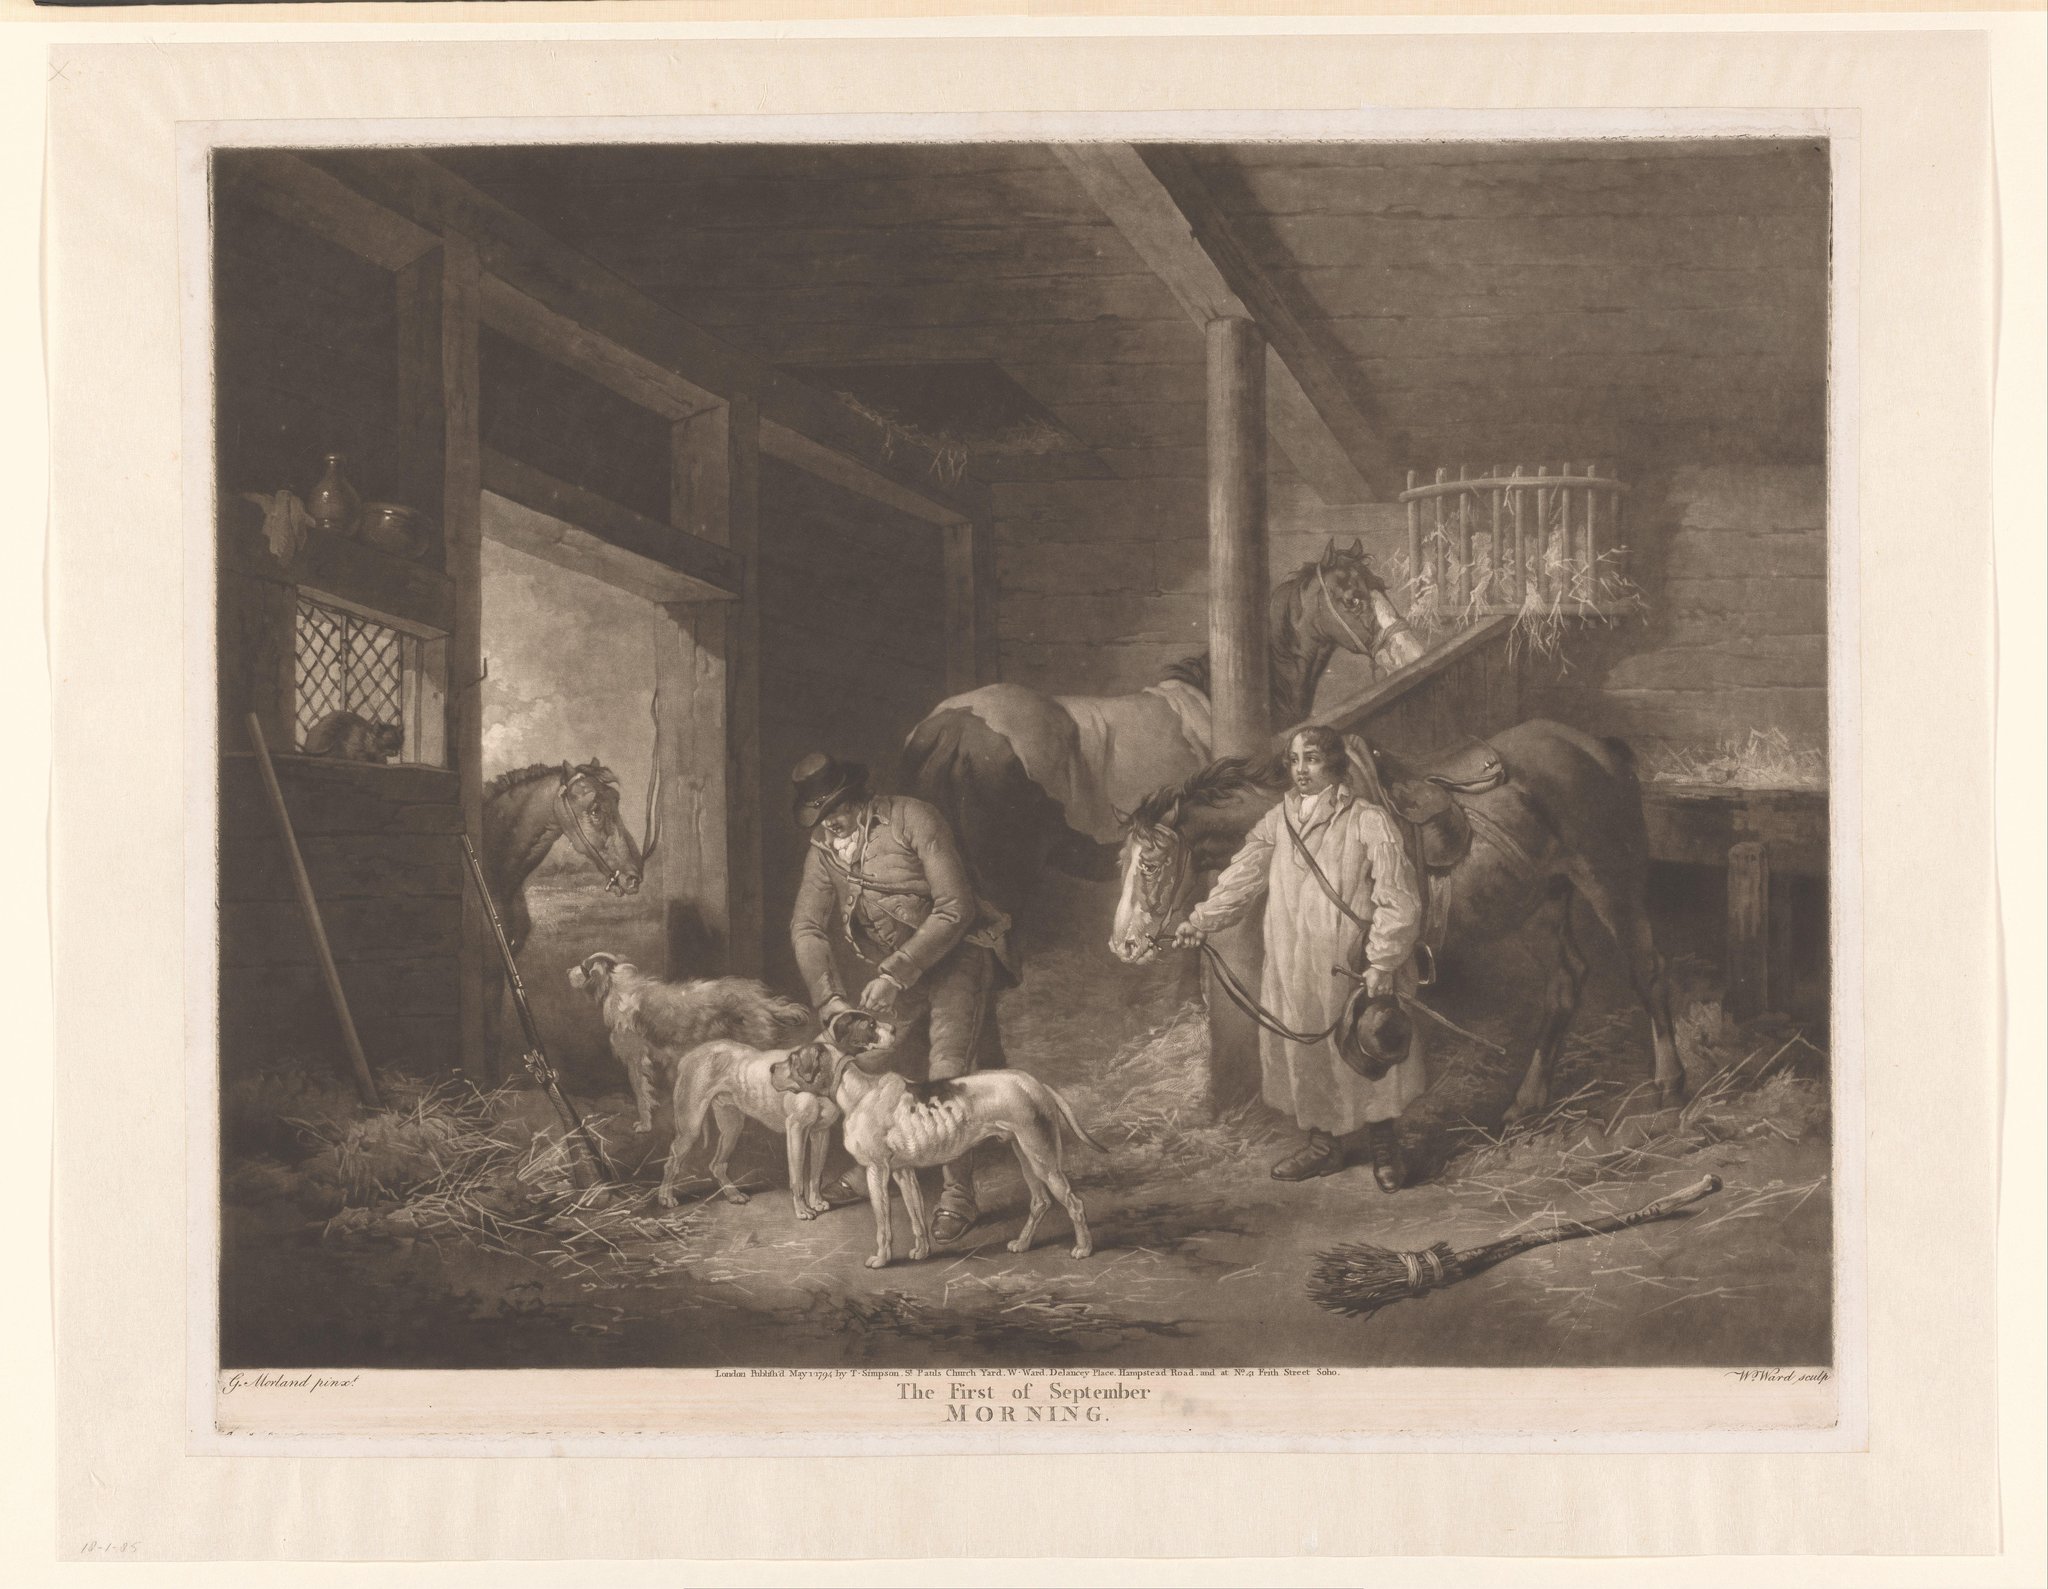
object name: print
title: The First of September, Morning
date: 1794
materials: paper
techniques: drypoint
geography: london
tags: hunting dogs, assembling, 'départ pour la chasse', stall, stable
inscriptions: collector's mark: Lugt 2228, number: ‘N. 171’